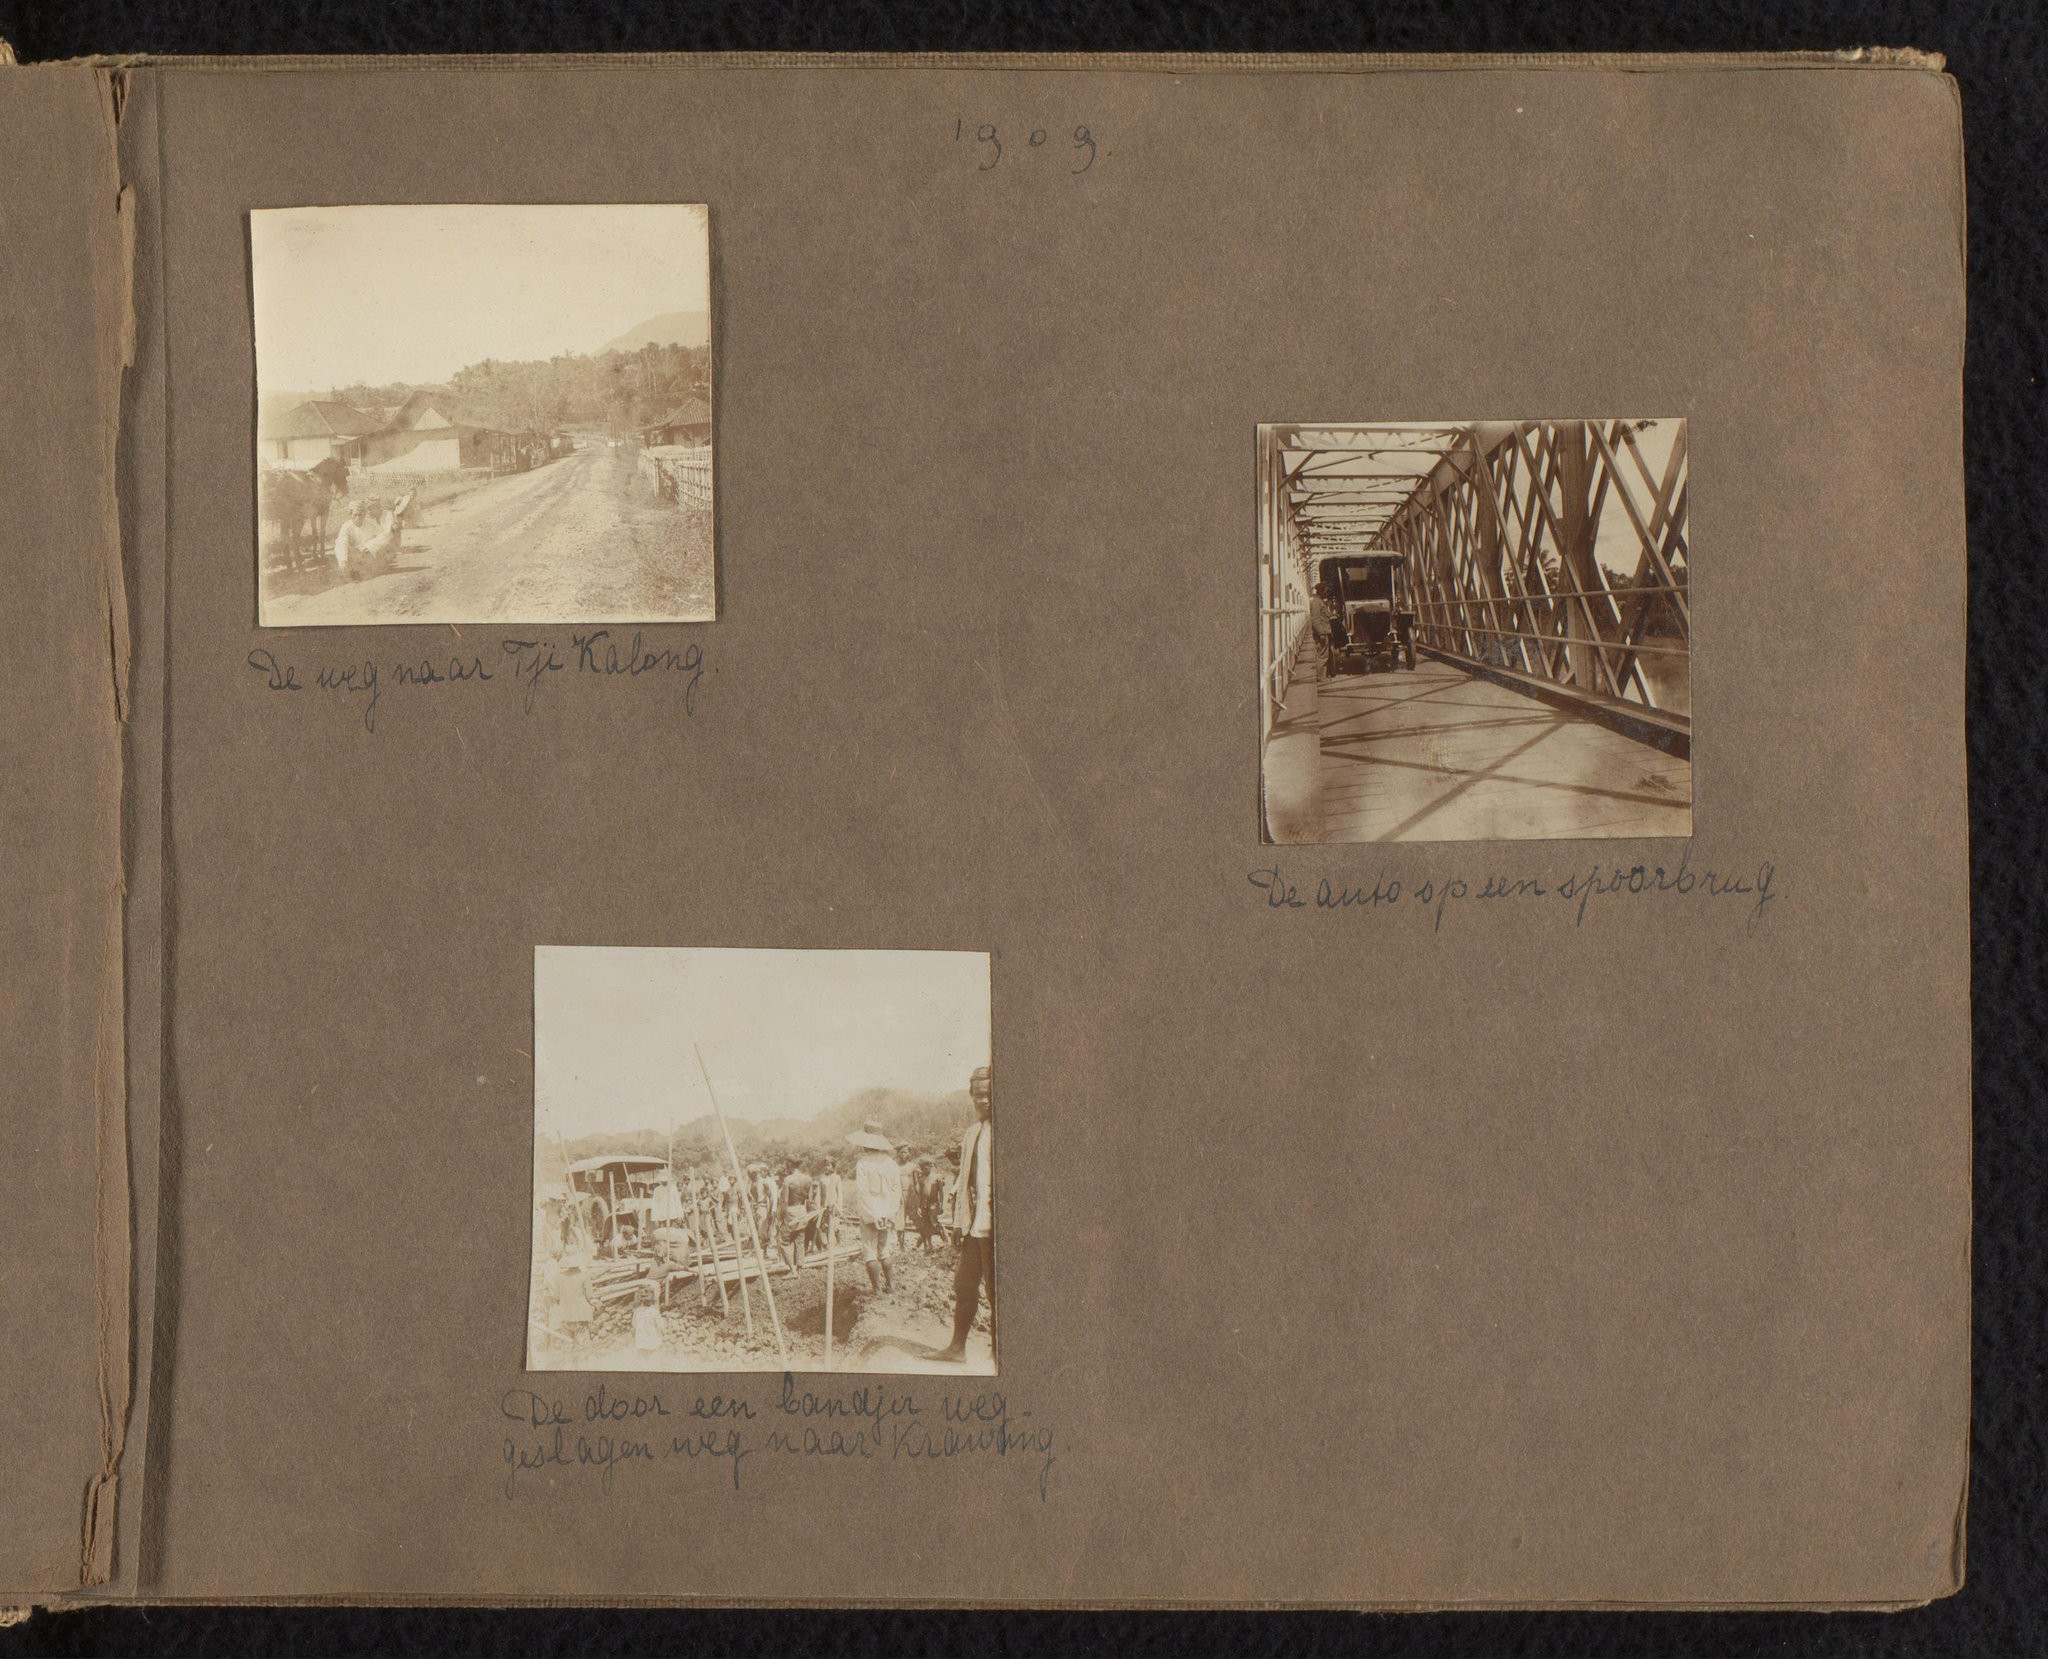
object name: album leaf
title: Drie foto's van de weg tussen Wanasari en Tji Kalong, Java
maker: carolina frederika onnen (lien/loen)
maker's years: 1896-1983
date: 1909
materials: paper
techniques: gelatin silver print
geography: central java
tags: bridge, public road, java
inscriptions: inscription: ‘De auto op een spoorbrug’, inscription: ‘De weg naar Tji Kalong’, inscription: ‘De door een bandjir weg-/ geslagen weg naar Krawung.’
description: Deze foto's maken deel uit van een album.